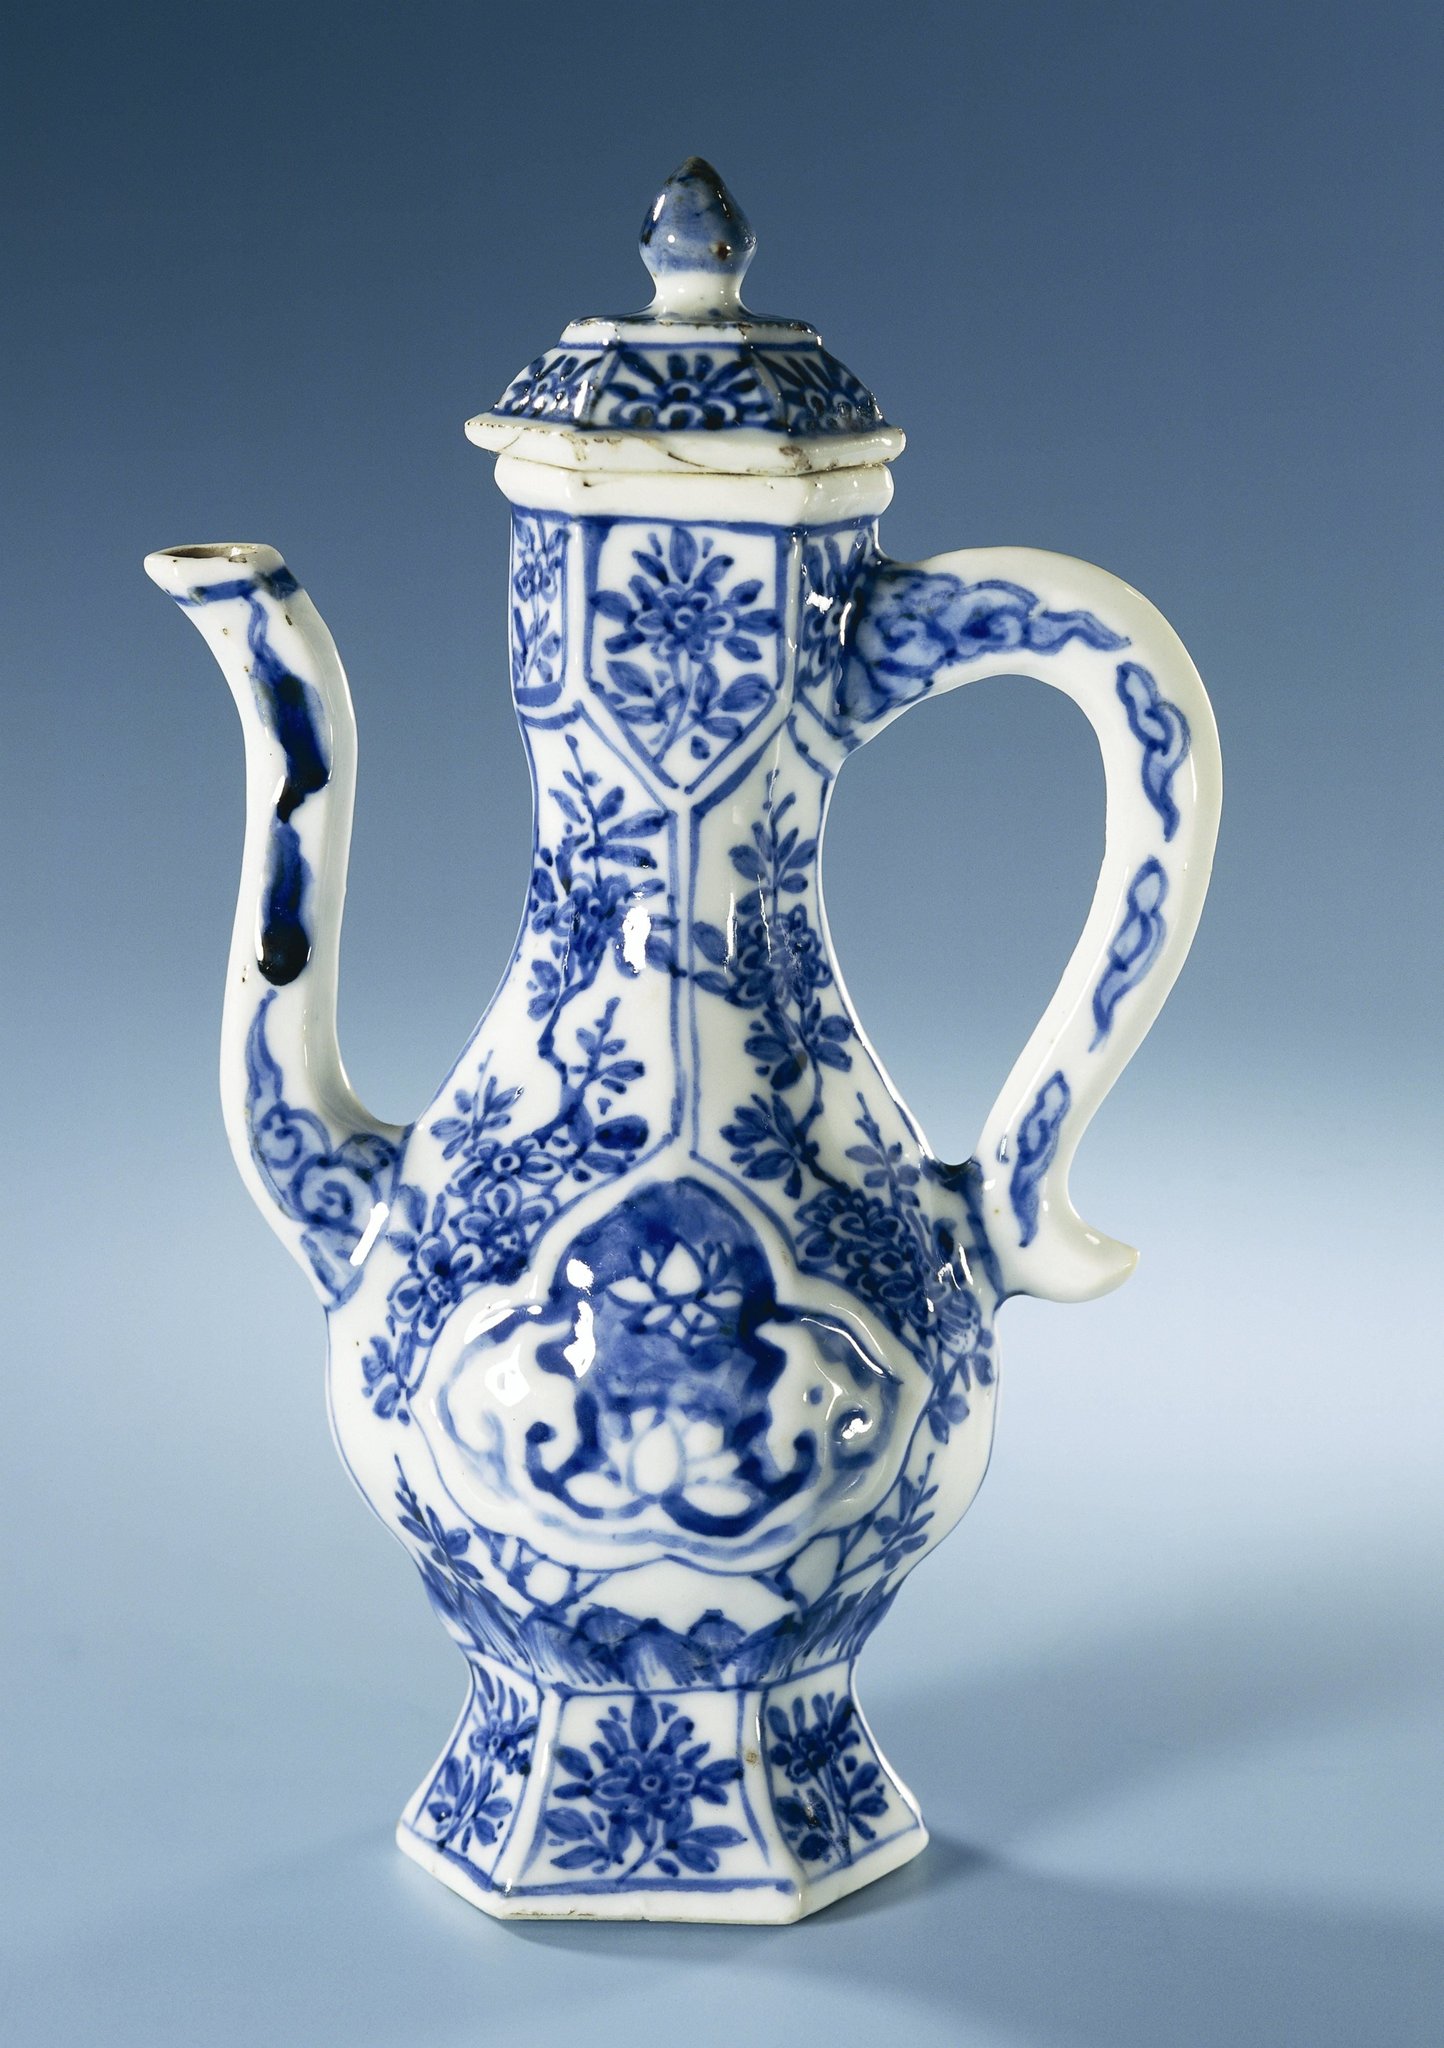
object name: ewer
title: Hexagonal ewer with flowering plants and floral scrolls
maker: Anonymous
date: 1700-1724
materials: cobalt, glaze, paint, porcelain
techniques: firing, forming, turning, vitrification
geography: china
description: Zeshoekige kan van porselein met een peervormig lichaam, lange, S-vormige tuit en S-vormig oor, beschilderd in onderglazuur blauw. Op de buik bloeiende planten onderbroken door een gemodelleerd, gelobd cartouche met één gemodelleerde en één in blauw uitgespaarde lotusrank. De voet, rand en deksel zijn verdeeld in zes vakken met bloemtakken. Op de tuit en het oor wolkmotieven. Blauw-wit.